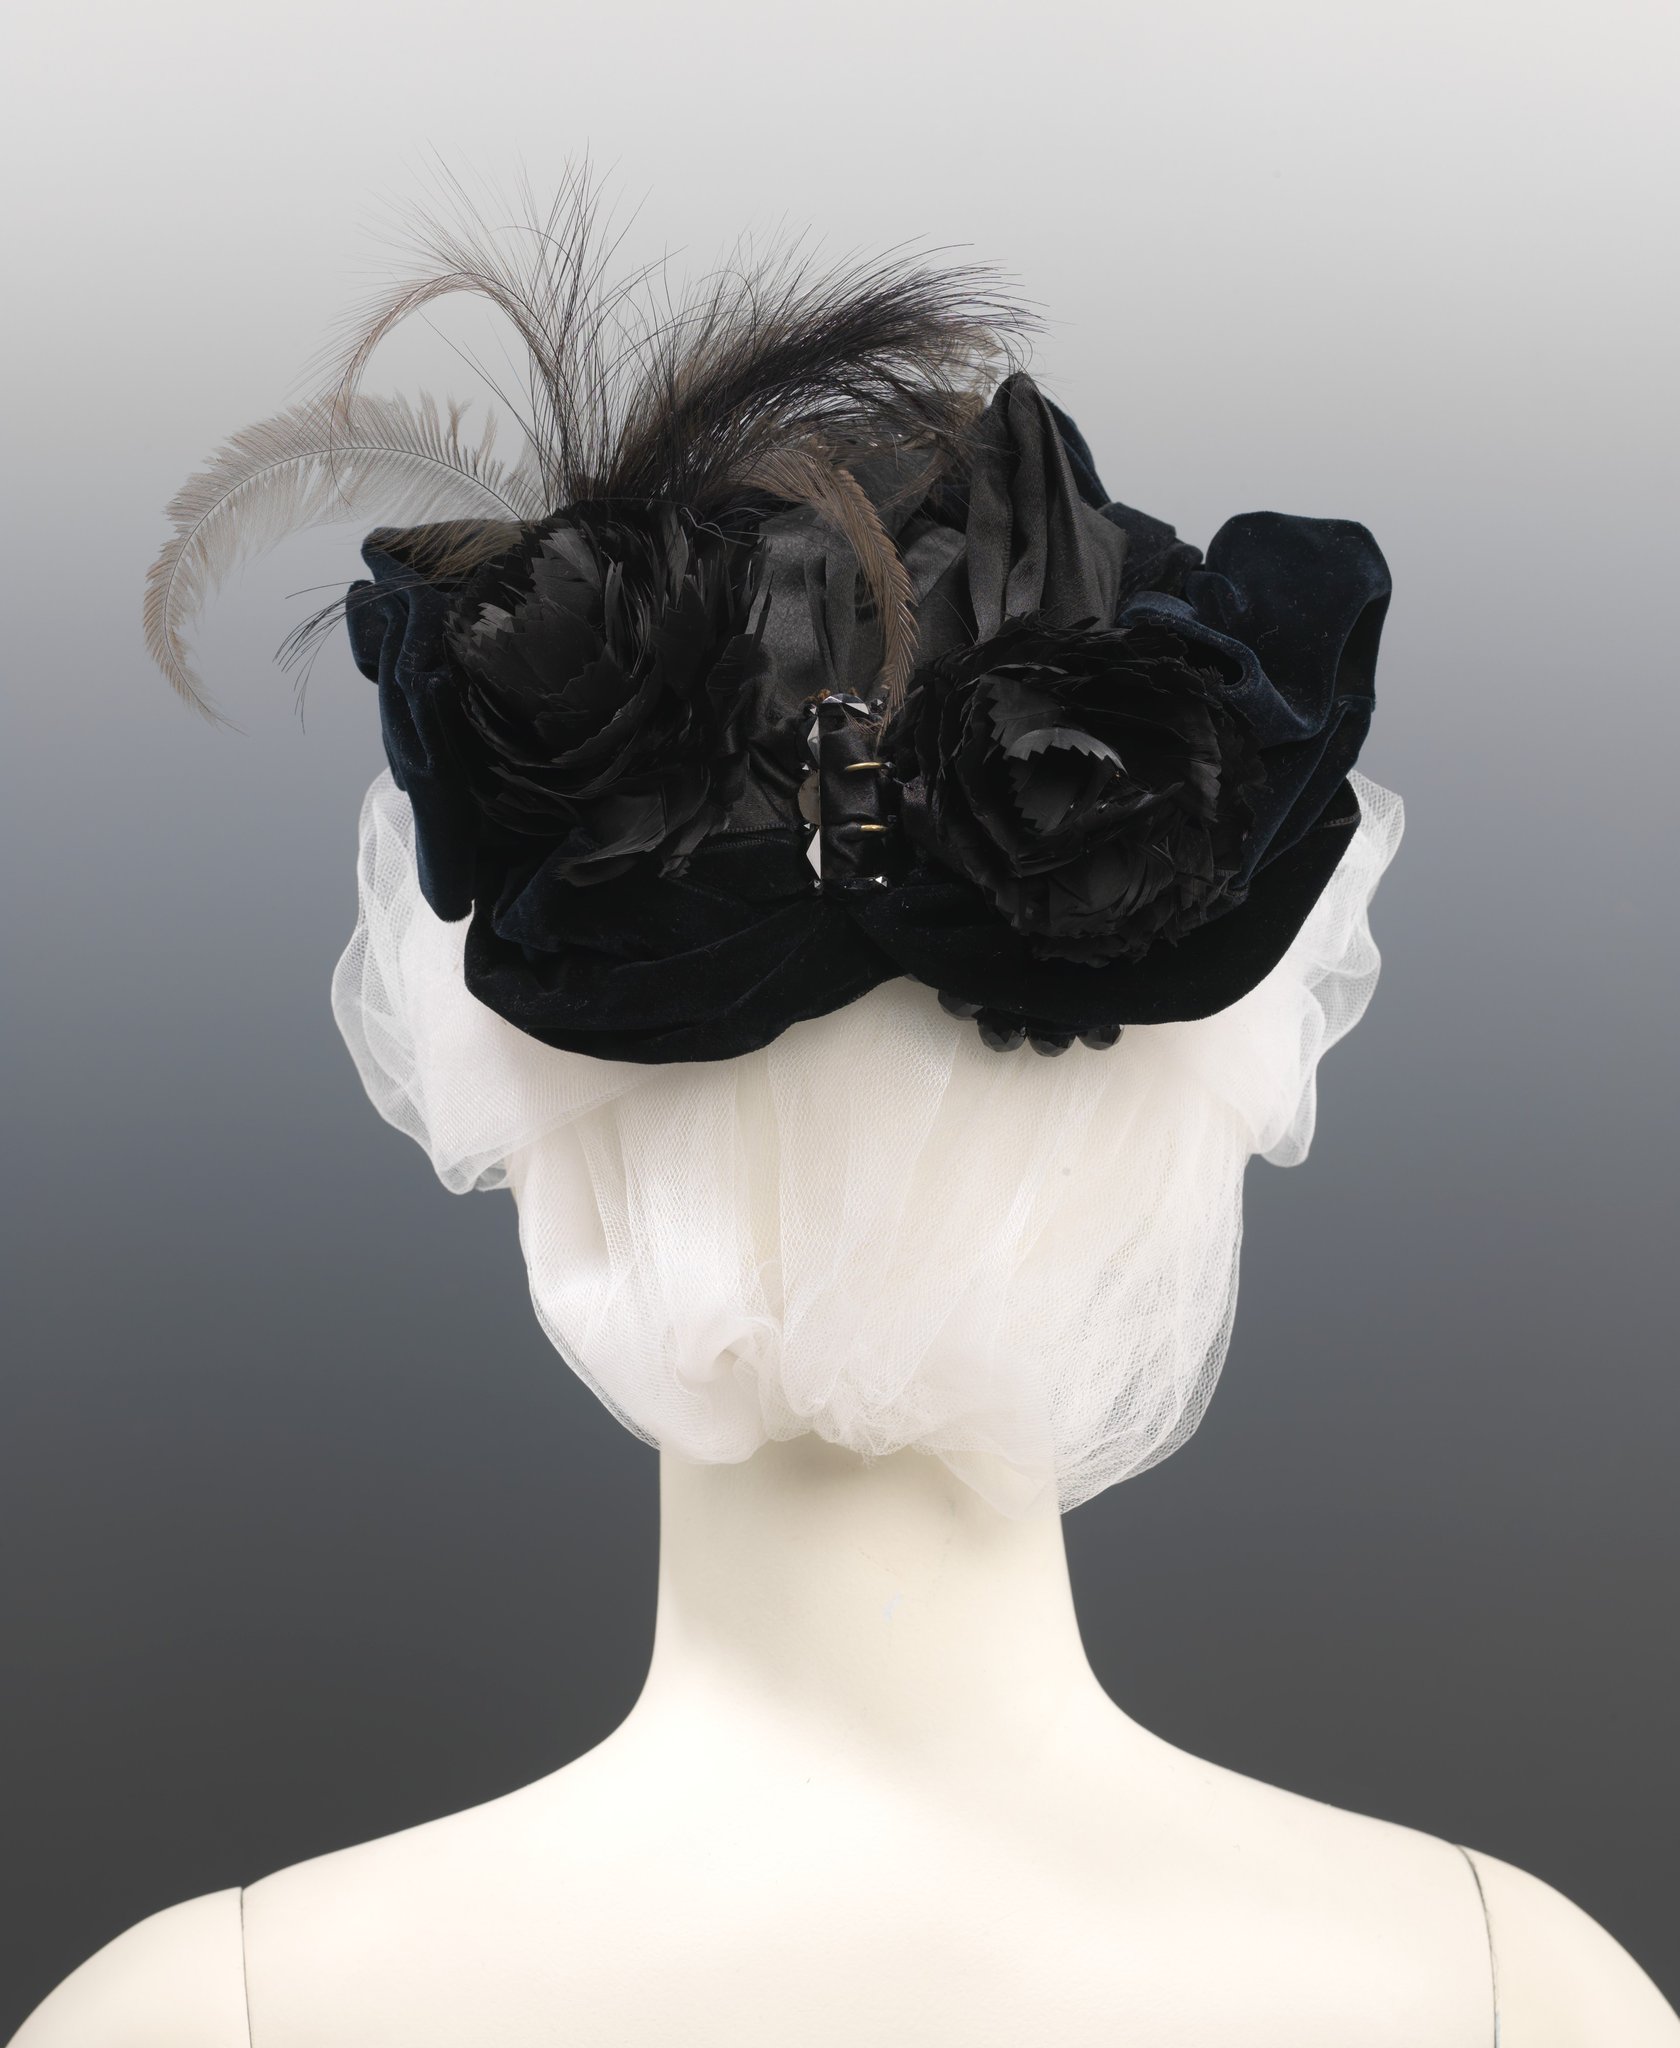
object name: evening hat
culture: american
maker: atherton fine millinery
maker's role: designer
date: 1885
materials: feather, metal, silk